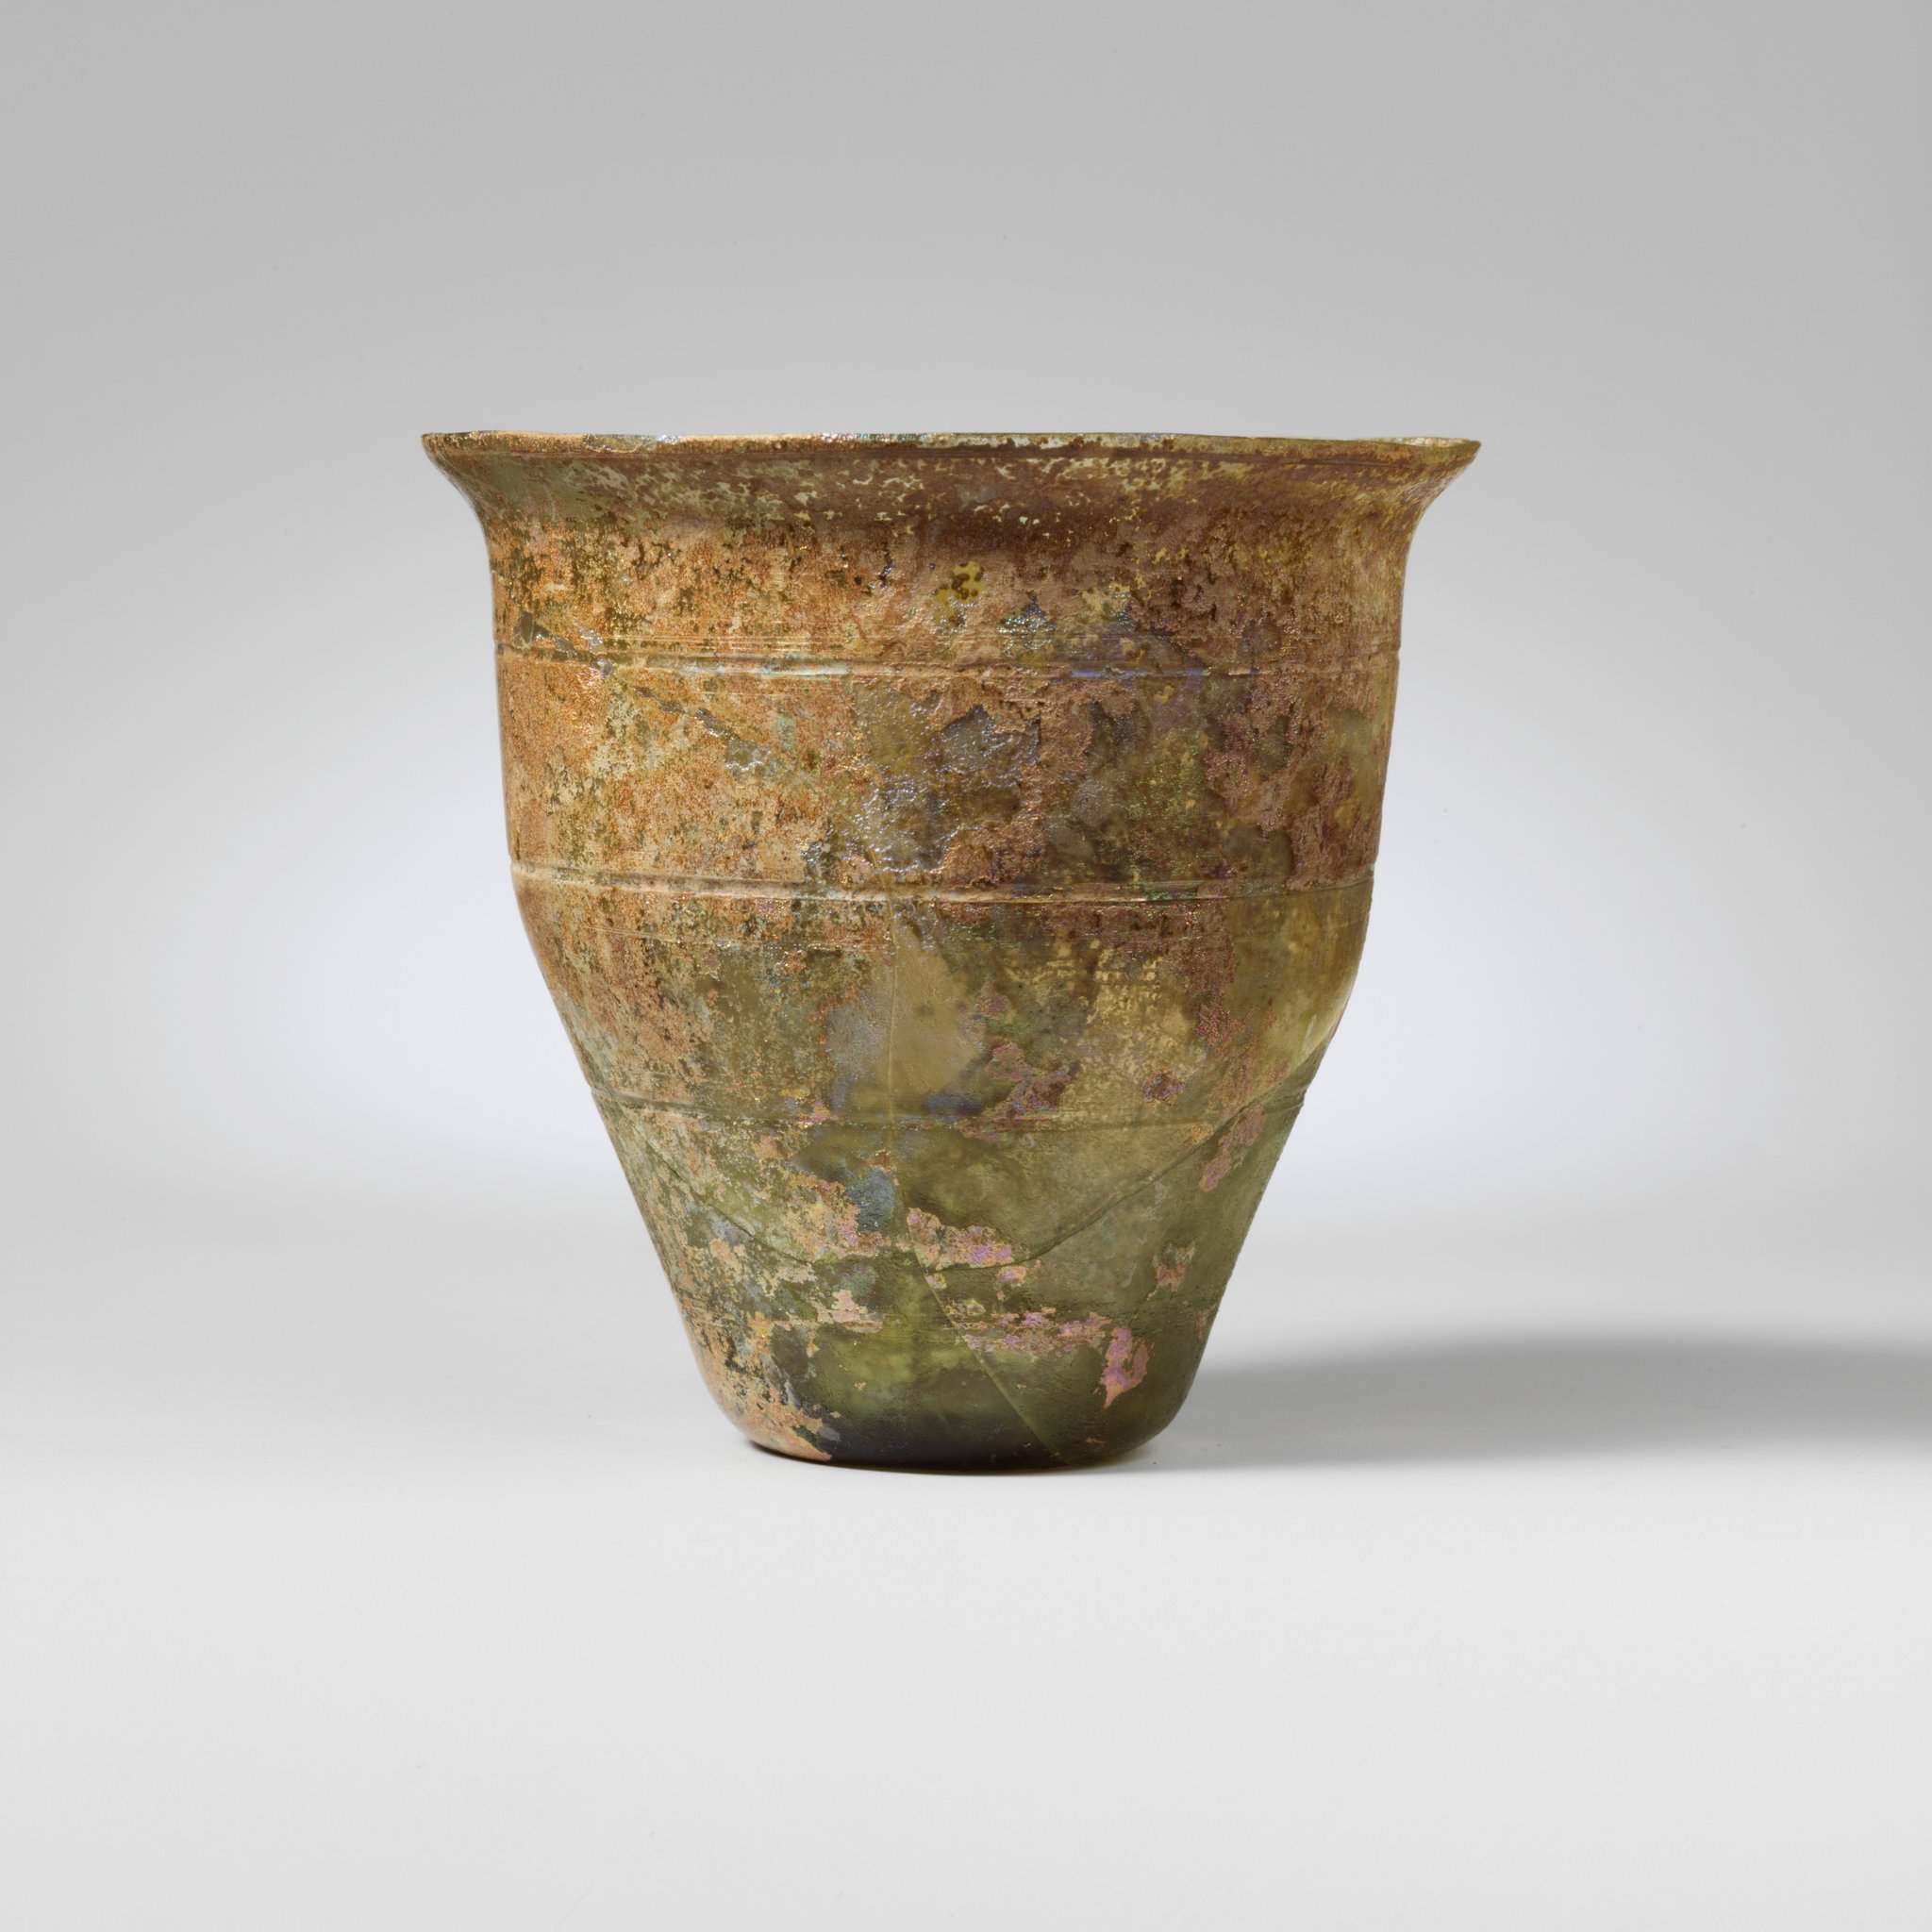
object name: cup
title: Glass cup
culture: roman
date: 1-200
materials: glass